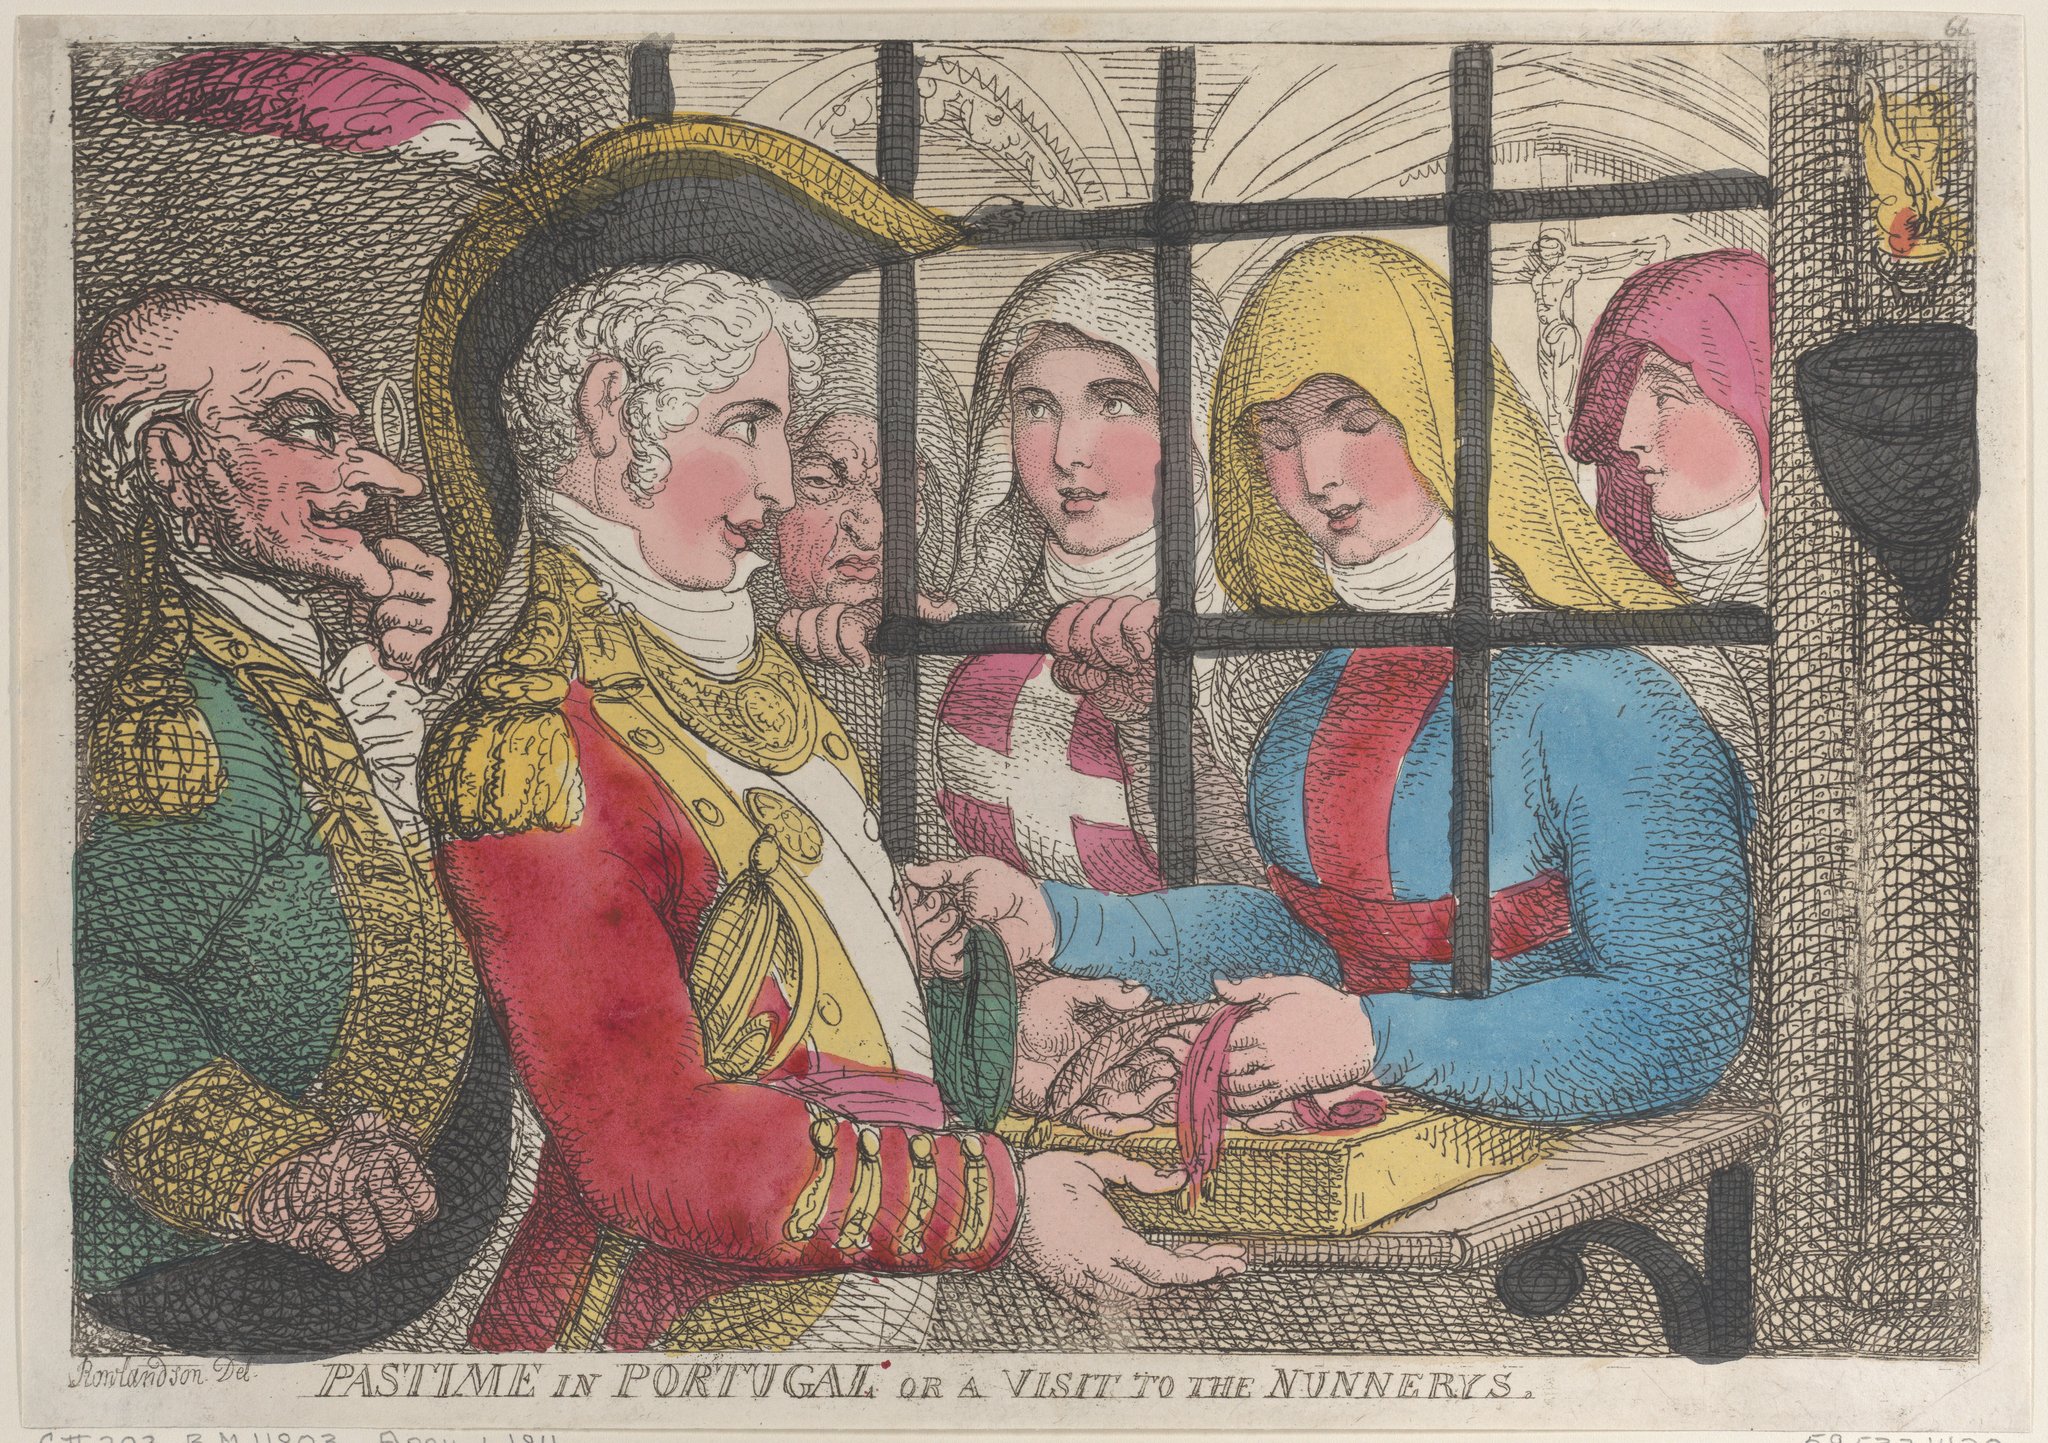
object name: print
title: Pastime in Portugal or a Visit to the Nunnerys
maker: thomas rowlandson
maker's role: artist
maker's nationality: british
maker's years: 1757-1827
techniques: etching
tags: satire,men,women